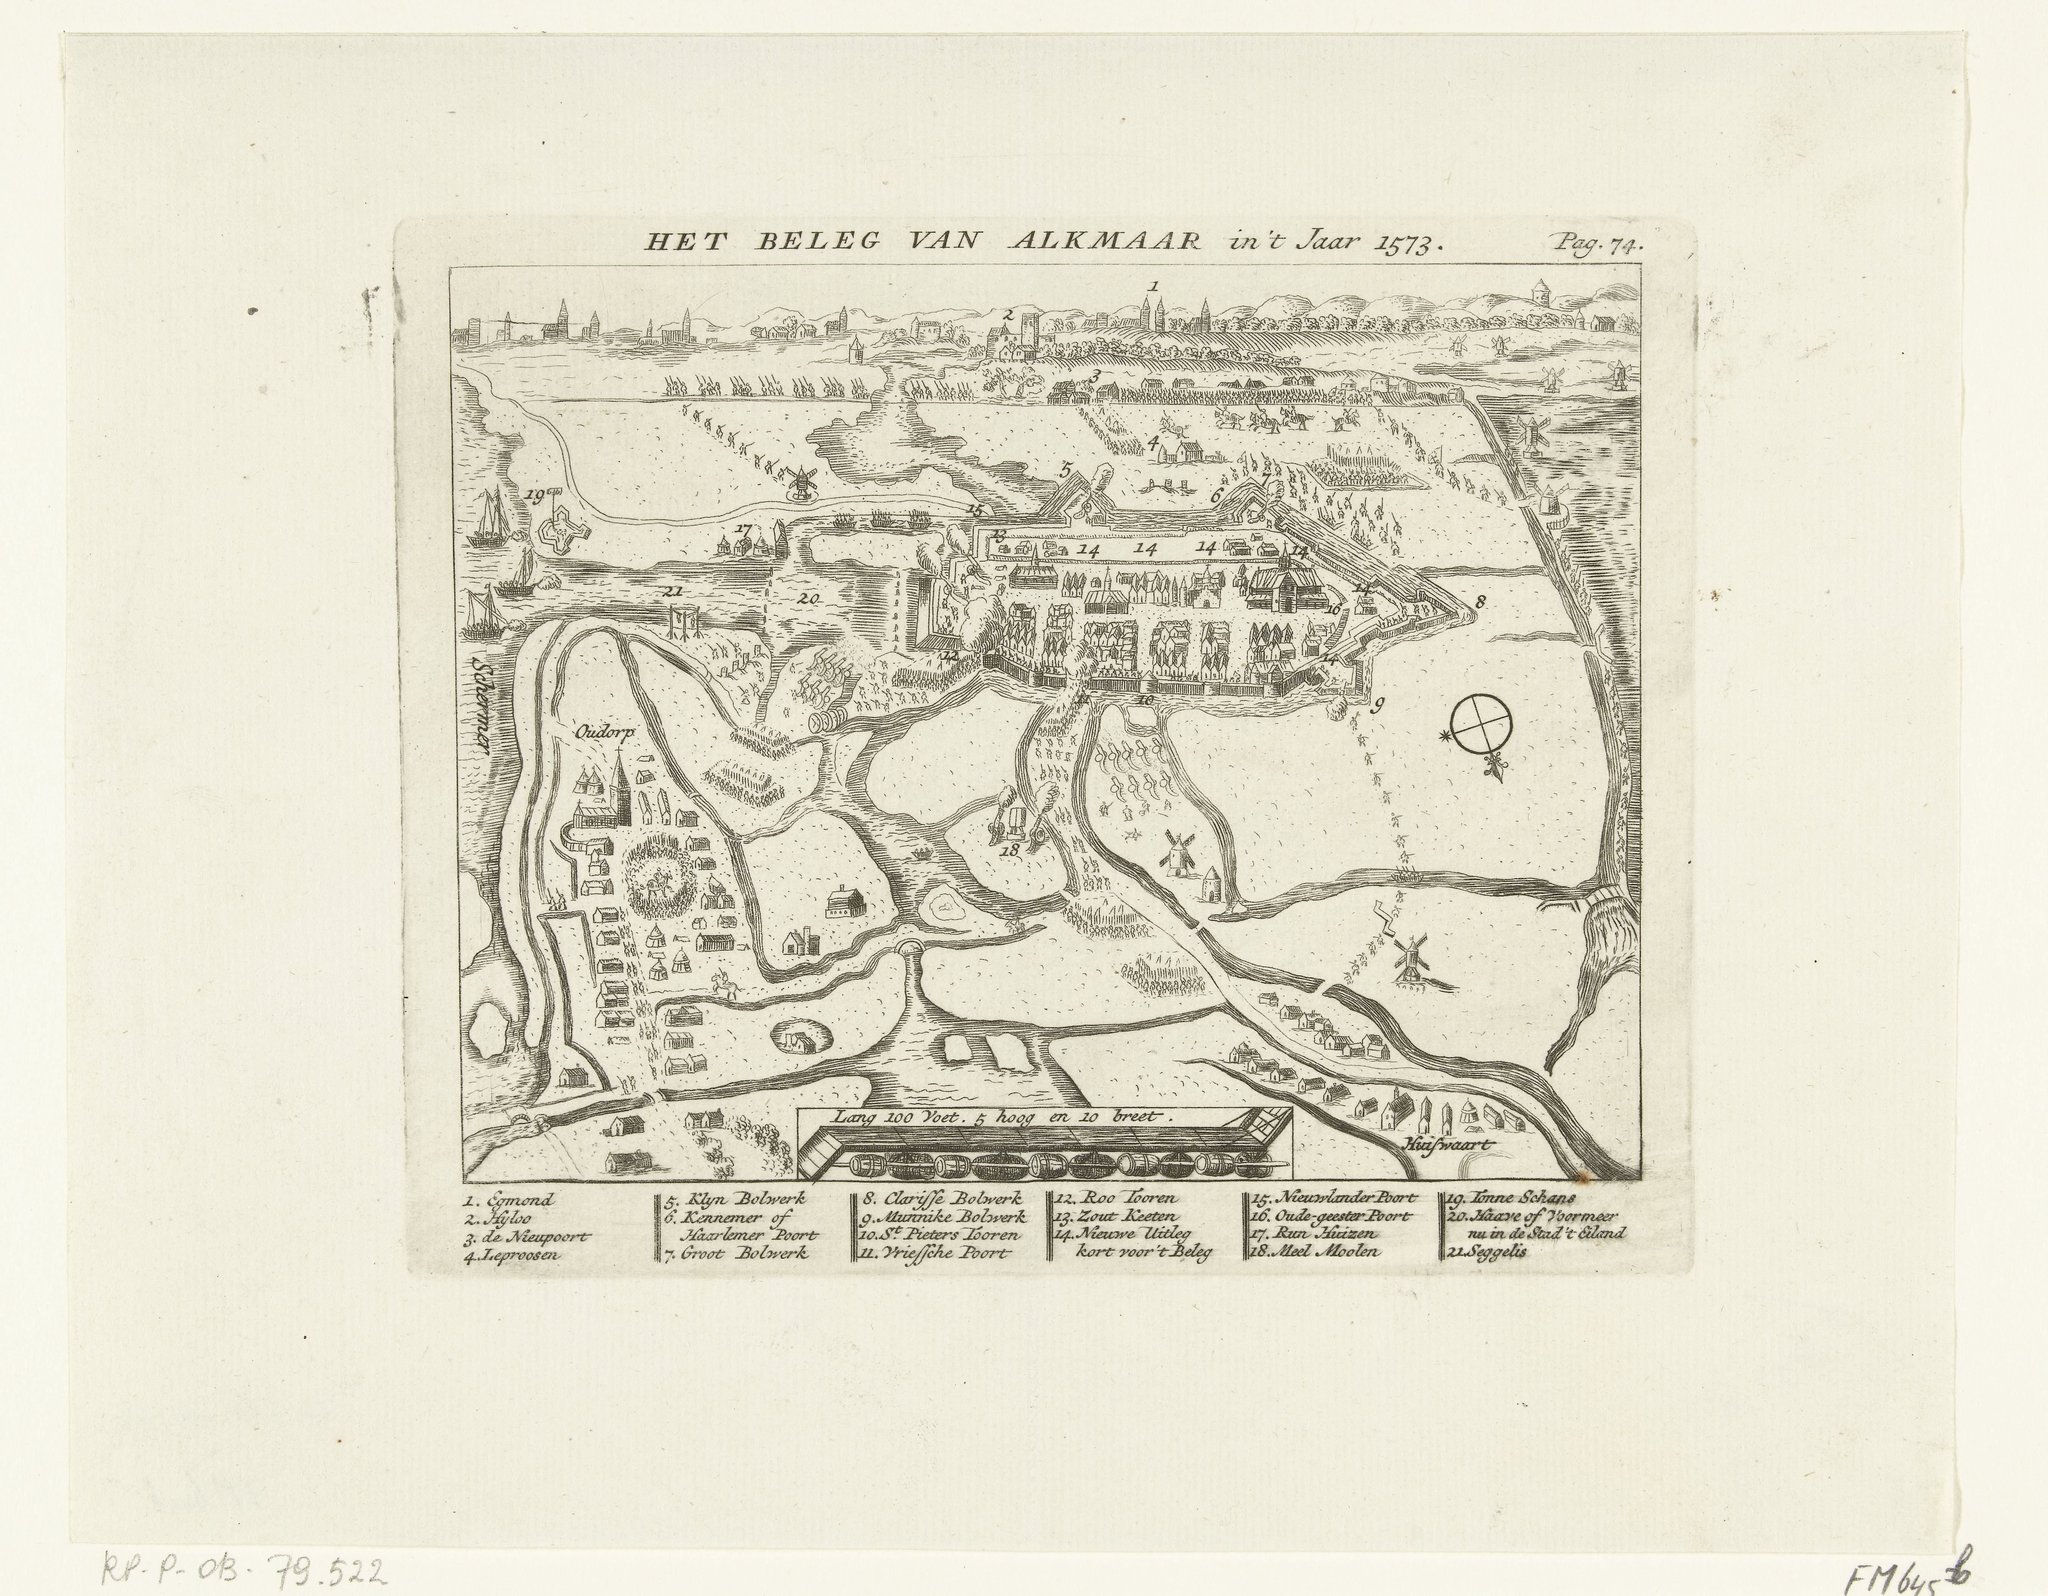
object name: print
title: Beleg van Alkmaar, 1573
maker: Anonymous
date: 1737-1739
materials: paper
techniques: etching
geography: northern netherlands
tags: siege, position war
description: Gebruikt als illustratie in: Nanning van Foreest, Kort verhaal van de belegering van Alkmaar, welke de Spanjaard na zeeven weken met zyne groote schaade en schande heeft moeten opbreeken in het jaar 1573: waar by koomen de onuitgegeeve aanteekeningen van een ander oog getuigen, J. Marshoorn en P. van Assendelft, Haarlem 1739, p. 74. Staat met de pagina-aanduiding. Deze staat niet in Frederik Muller; door het RPK toegevoegd nummer. Kopie naar de prent in Baudartius.